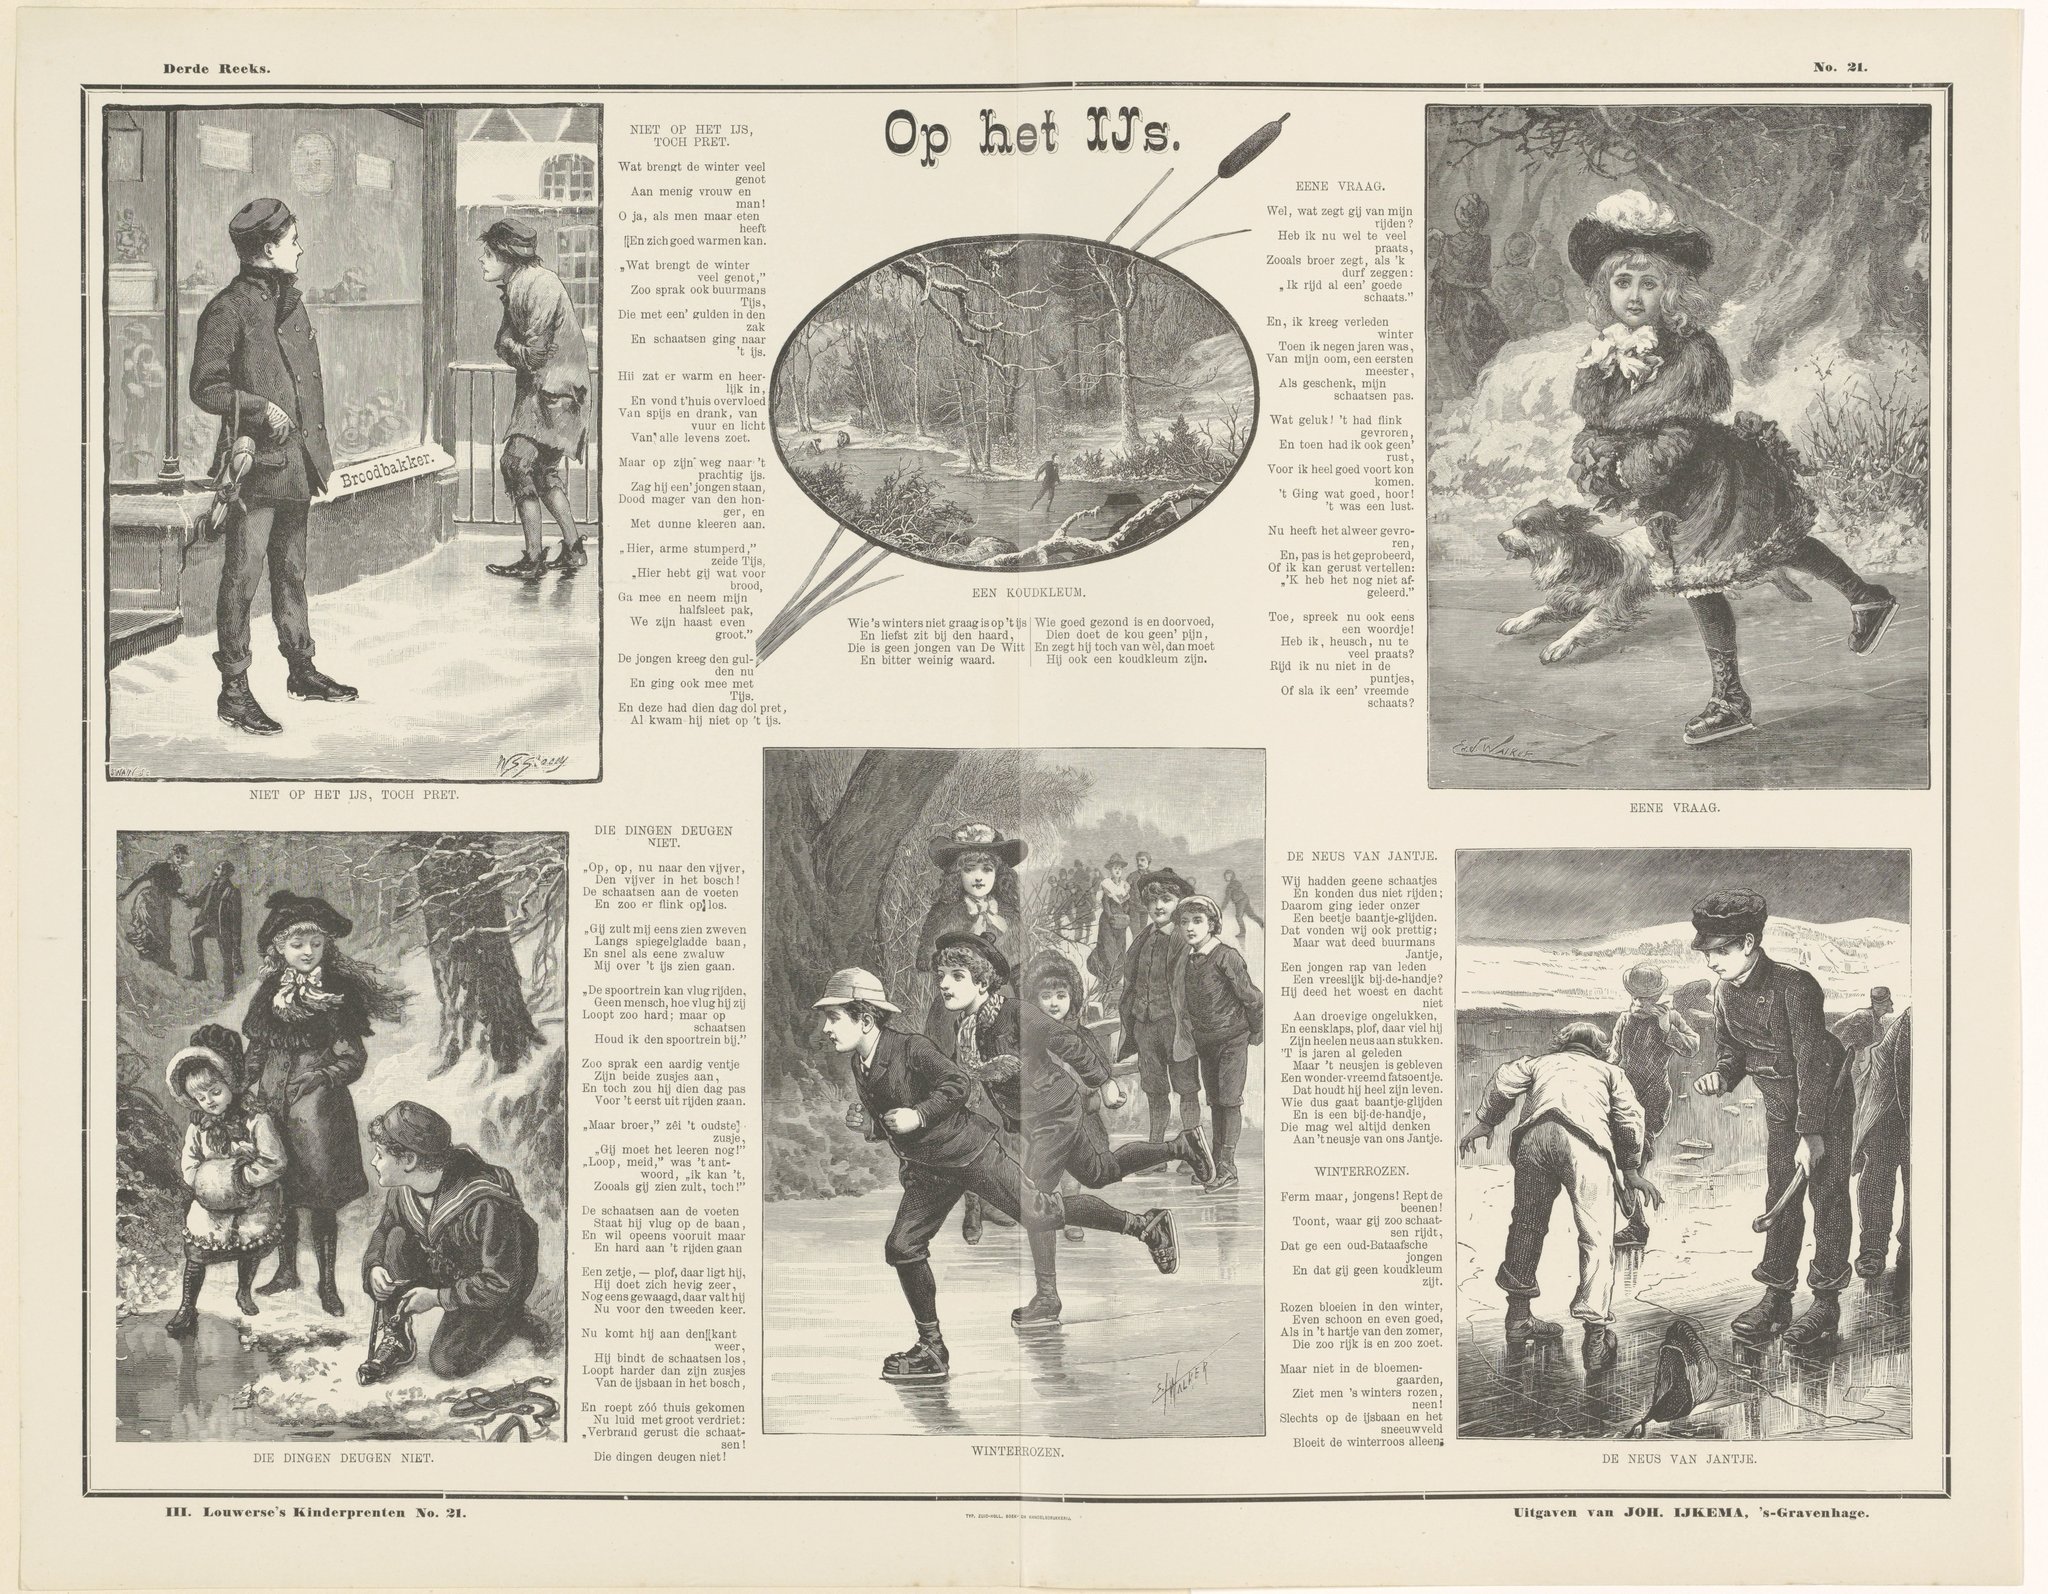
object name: print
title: Op het ijs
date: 1892-1905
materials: paper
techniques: letterpress printing, printing block, engraving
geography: the hague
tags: skates (winter sports), playing with snow and ice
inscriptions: collector's mark: Lugt 2760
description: Blad met 6 voorstellingen van volwassenen en kinderen in de sneeuw en op het ijs. Tussen de afbeeldingen versjes in boekdruk. Genummerd rechtsboven en linksonder: No. 21.